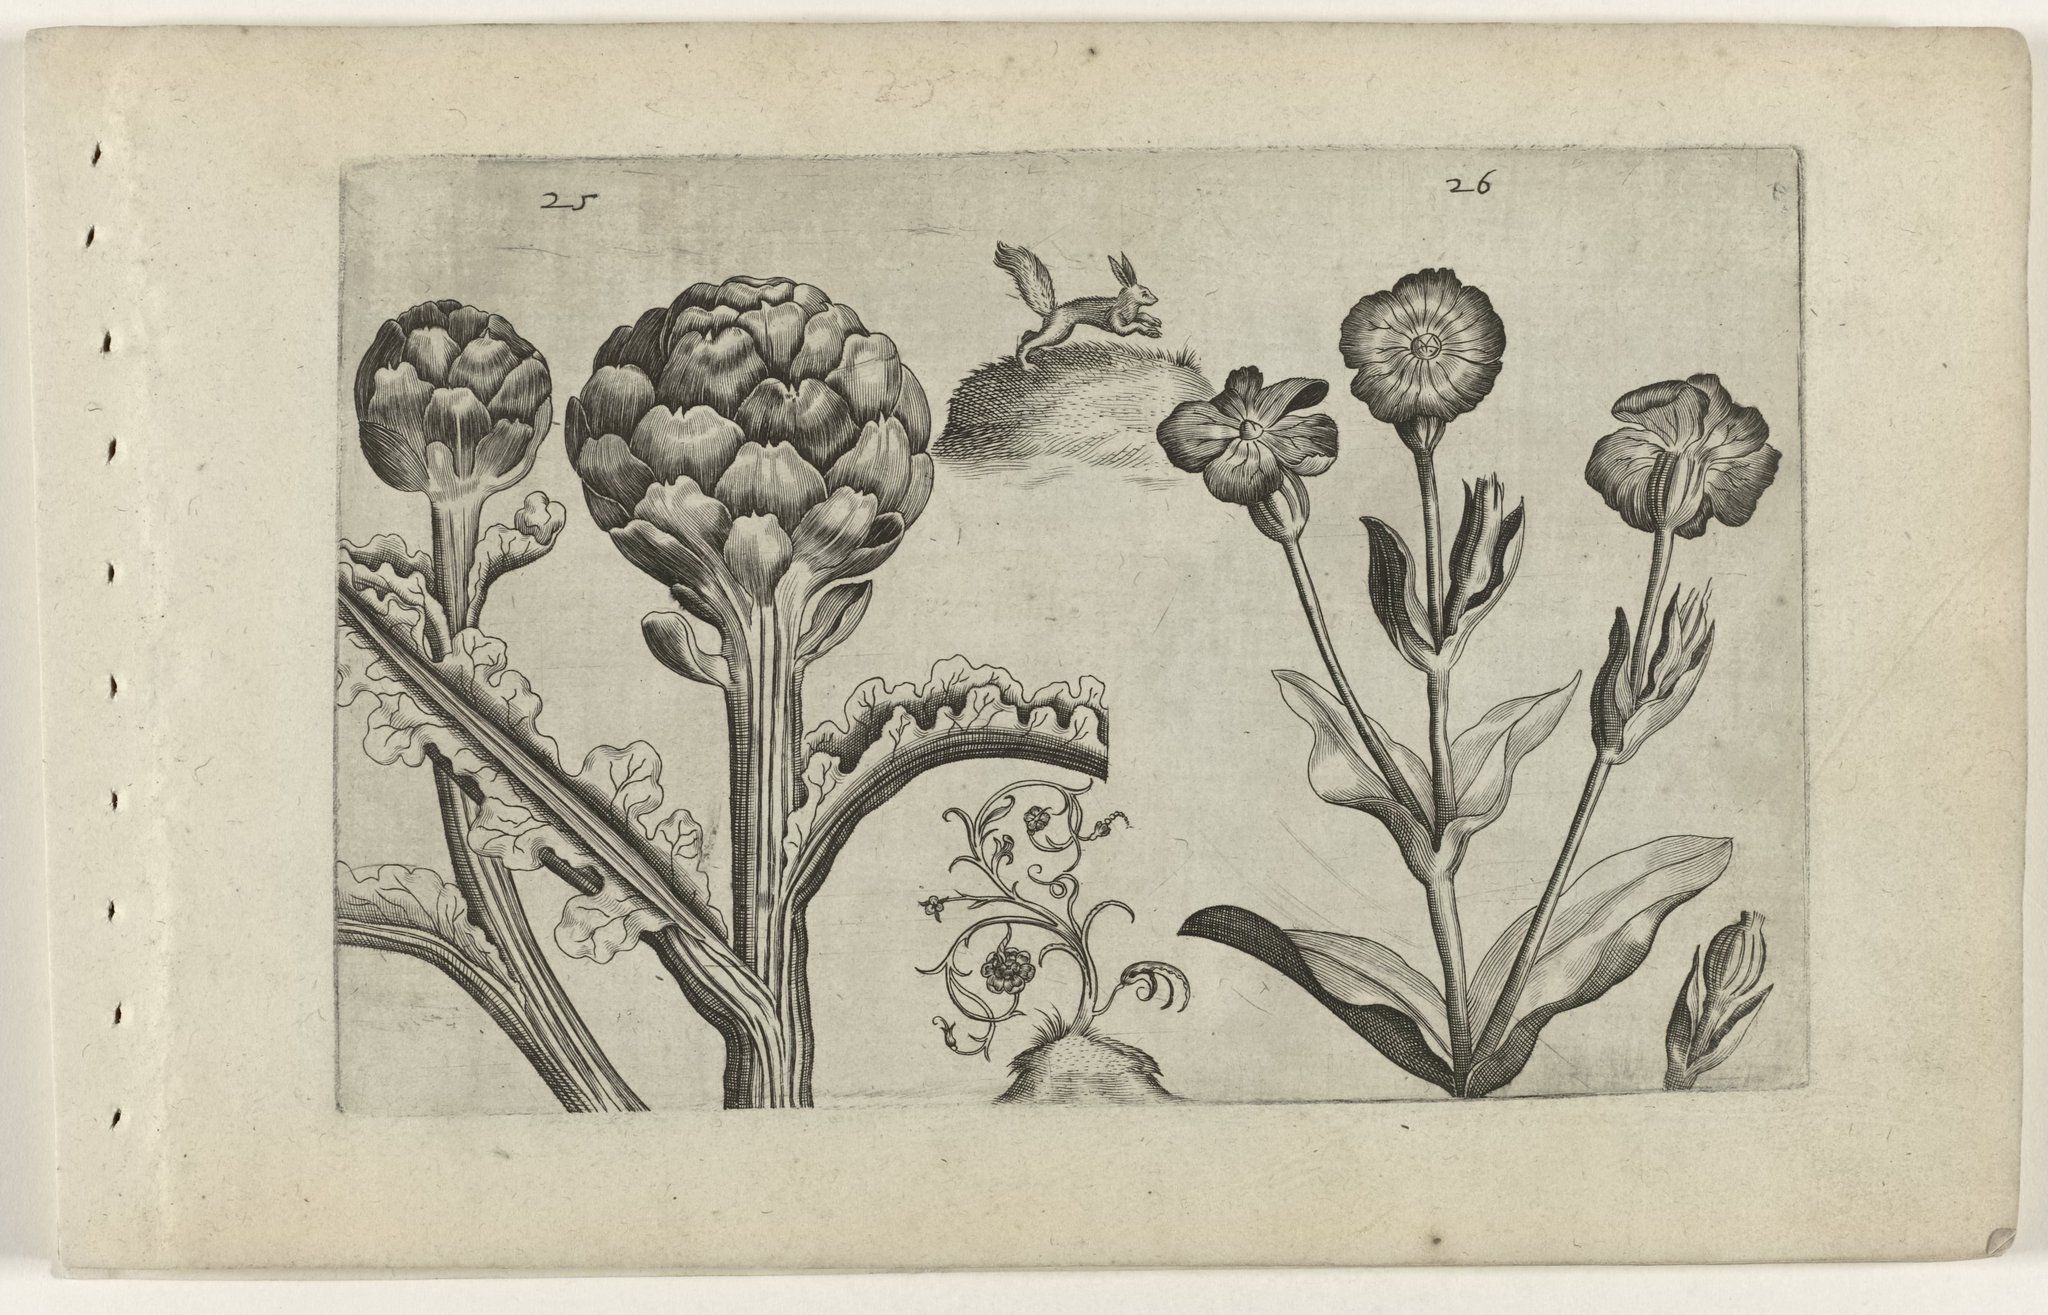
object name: album leaf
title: Cognoscite lilia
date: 1600-1604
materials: paper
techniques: engraving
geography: cologne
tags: flowers: silene coronaria, botany, rodents: squirrel, plants and herbs: artichoke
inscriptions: collector's mark: Lugt 2228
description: De prenten RP-P-2012-24-1 t/m 61 waren oorspronkelijk als serie samengebonden. De naaigaten op de bladen zijn nog zichtbaar. Het betreft de reeks getiteld: Cognoscite lilia, bestaande uit een titelprent en 60 gravures met 119 genummerde weergaven van planten, bloemen en vruchten, versierd met rinceaux en kleine voorstellingen van dieren. Het gaat om proefdrukken van deze reeks gravures, voor de opschriften en, deels, voor de nummering. Op enkele prenten zijn de nummers met de hand aangebracht. Op de titelprent ontbreekt nog het adres van Crispijn de Passe en Hans Woutneel. De titel is hoogstwaarschijnlijk gegraveerd door Matthias Quad. Deze werkte voor De Passe in Keulen tot 1604. De reeks moet in dit jaar of daarvoor tot stand zijn gebracht. In ieder geval voor 1608, aangezien de uitgever Hans Woutneel in of voor dat jaar overleed. In ieder geval voor 1608, aangezien de uitgever Hans Woutneel in of voor dat jaar overleed. De gravures worden door Ilja Veldman en Anthony Griffiths beschouwd als eigenhandig werk van Crispijn de Passe I. Een van de prenten uit de reeks ontbreekt (nr 21-22) en is vervangen door een ingekleurde afdruk uit een latere uitgave (RP-P-2012-24-61), die onder de titel Altera Pars is opgenomen in de Hortus Floridus, uitgegeven door Crispijn de Passe I en die verder bestaat uit platen van Crispijn de Passe II. De prenten afkomstig uit deze uitgave zijn op de verso voorzien van tekst in boekdruk. De vervangende prent maakte geen deel uit van de gebonden serie aangezien dit blad als enige geen naaigaten heeft. Een deel van de planten, bloemen en vruchten in de Cognoscite lilia gaat terug of is gebaseerd op een reeks aquarellen van Jacques LeMoyne uit circa 1580 en uit 1585, nu in het Victoria and Albert Museum en de British Museum (zie P. Hulton, Jacques LeMoyne, Londen 1977, dl 1, p. 156-162 en p. 165-173).